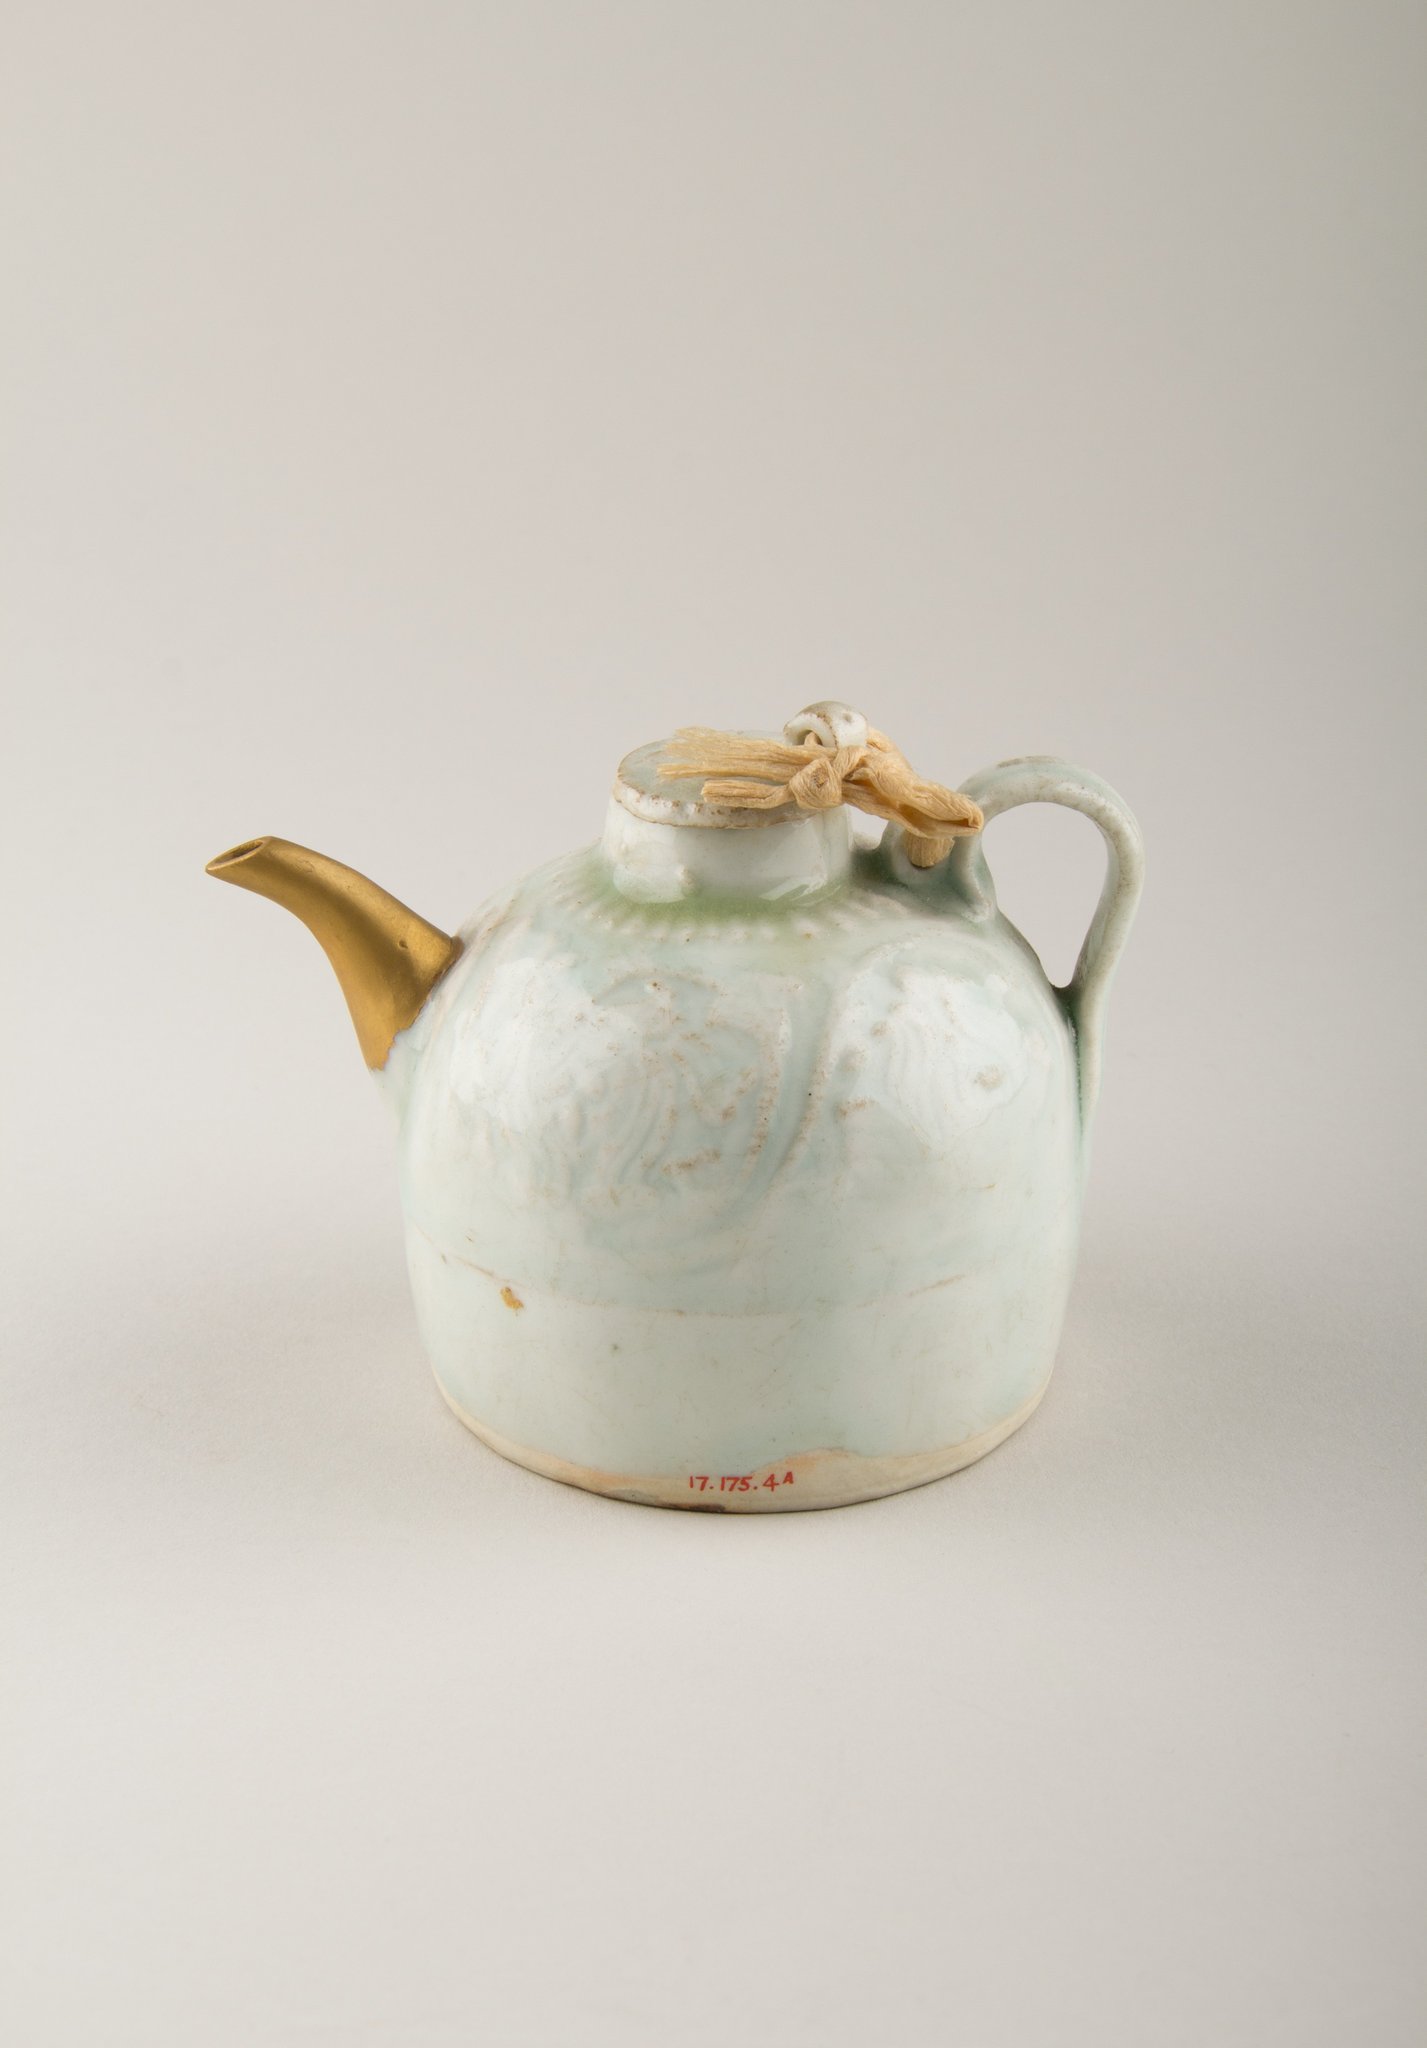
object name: bottle with cover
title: Bottle and cover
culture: chinese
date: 918-1392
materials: clay